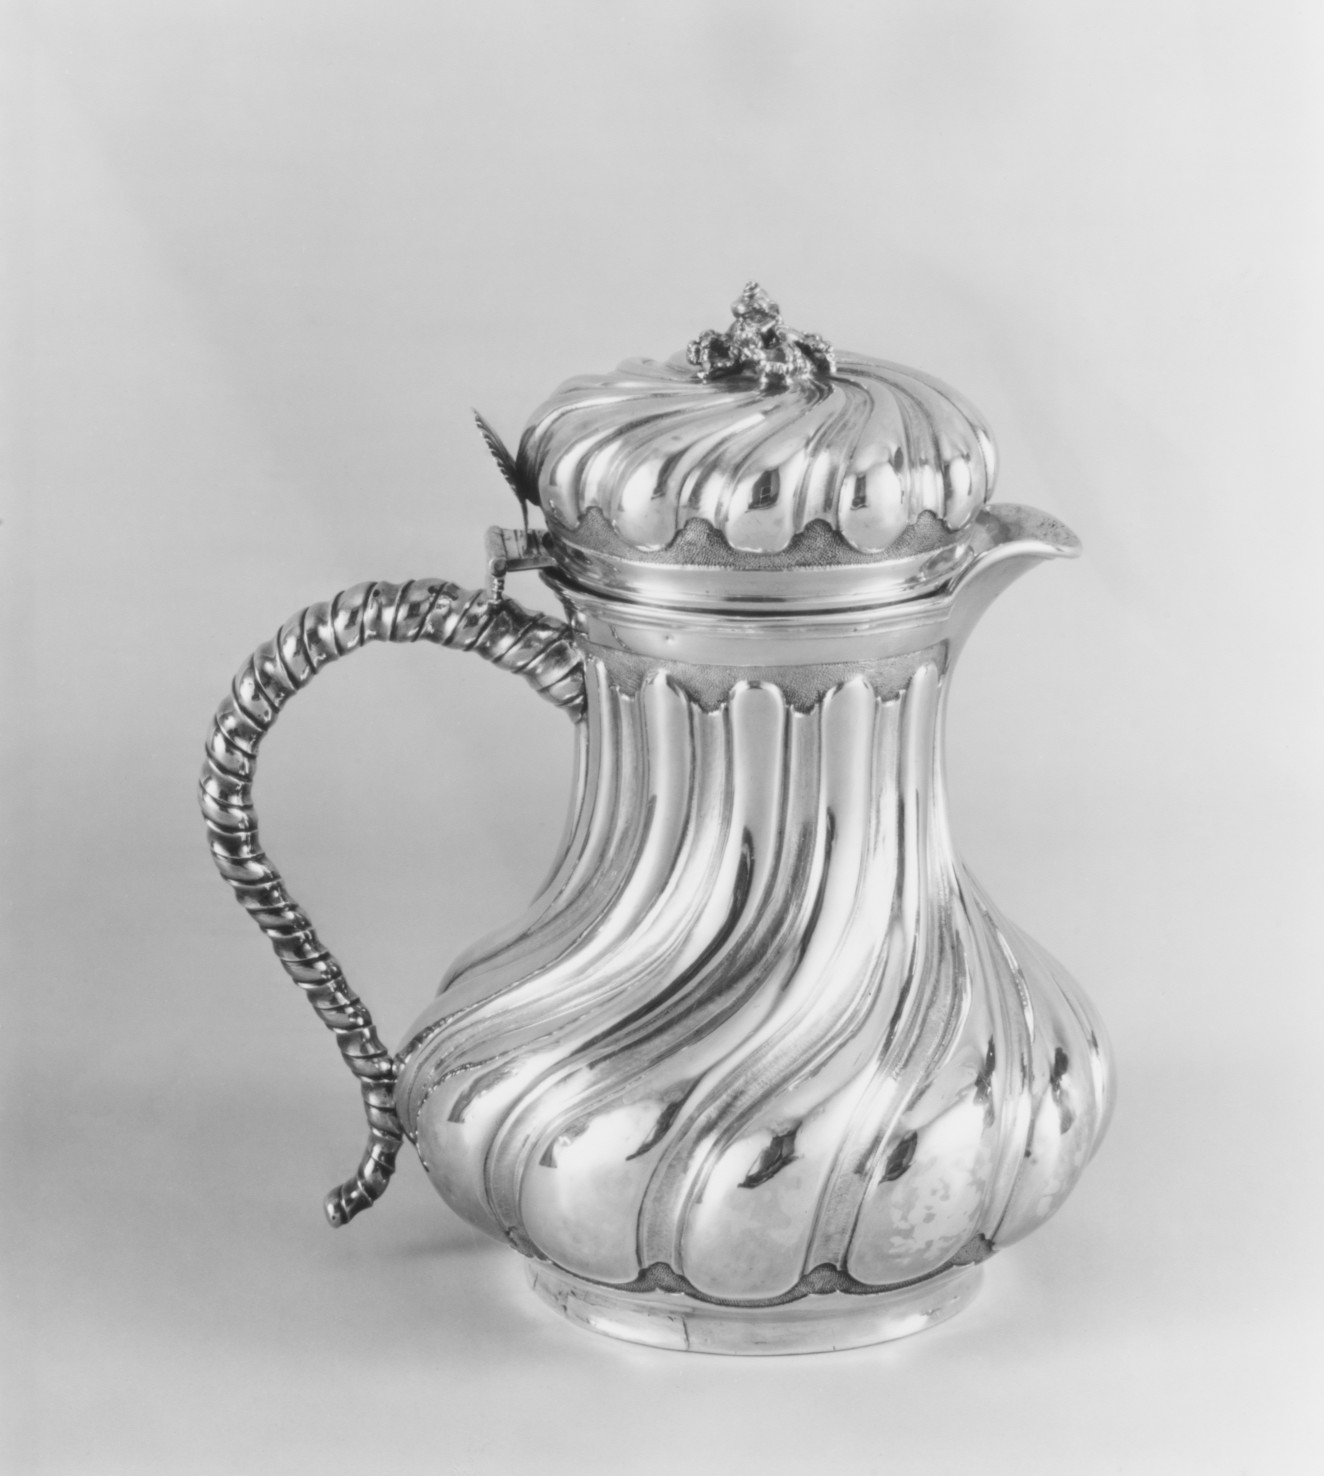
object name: coffeepot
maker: sébastien igonet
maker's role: maker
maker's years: 1695-1796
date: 1738-1739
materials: silver